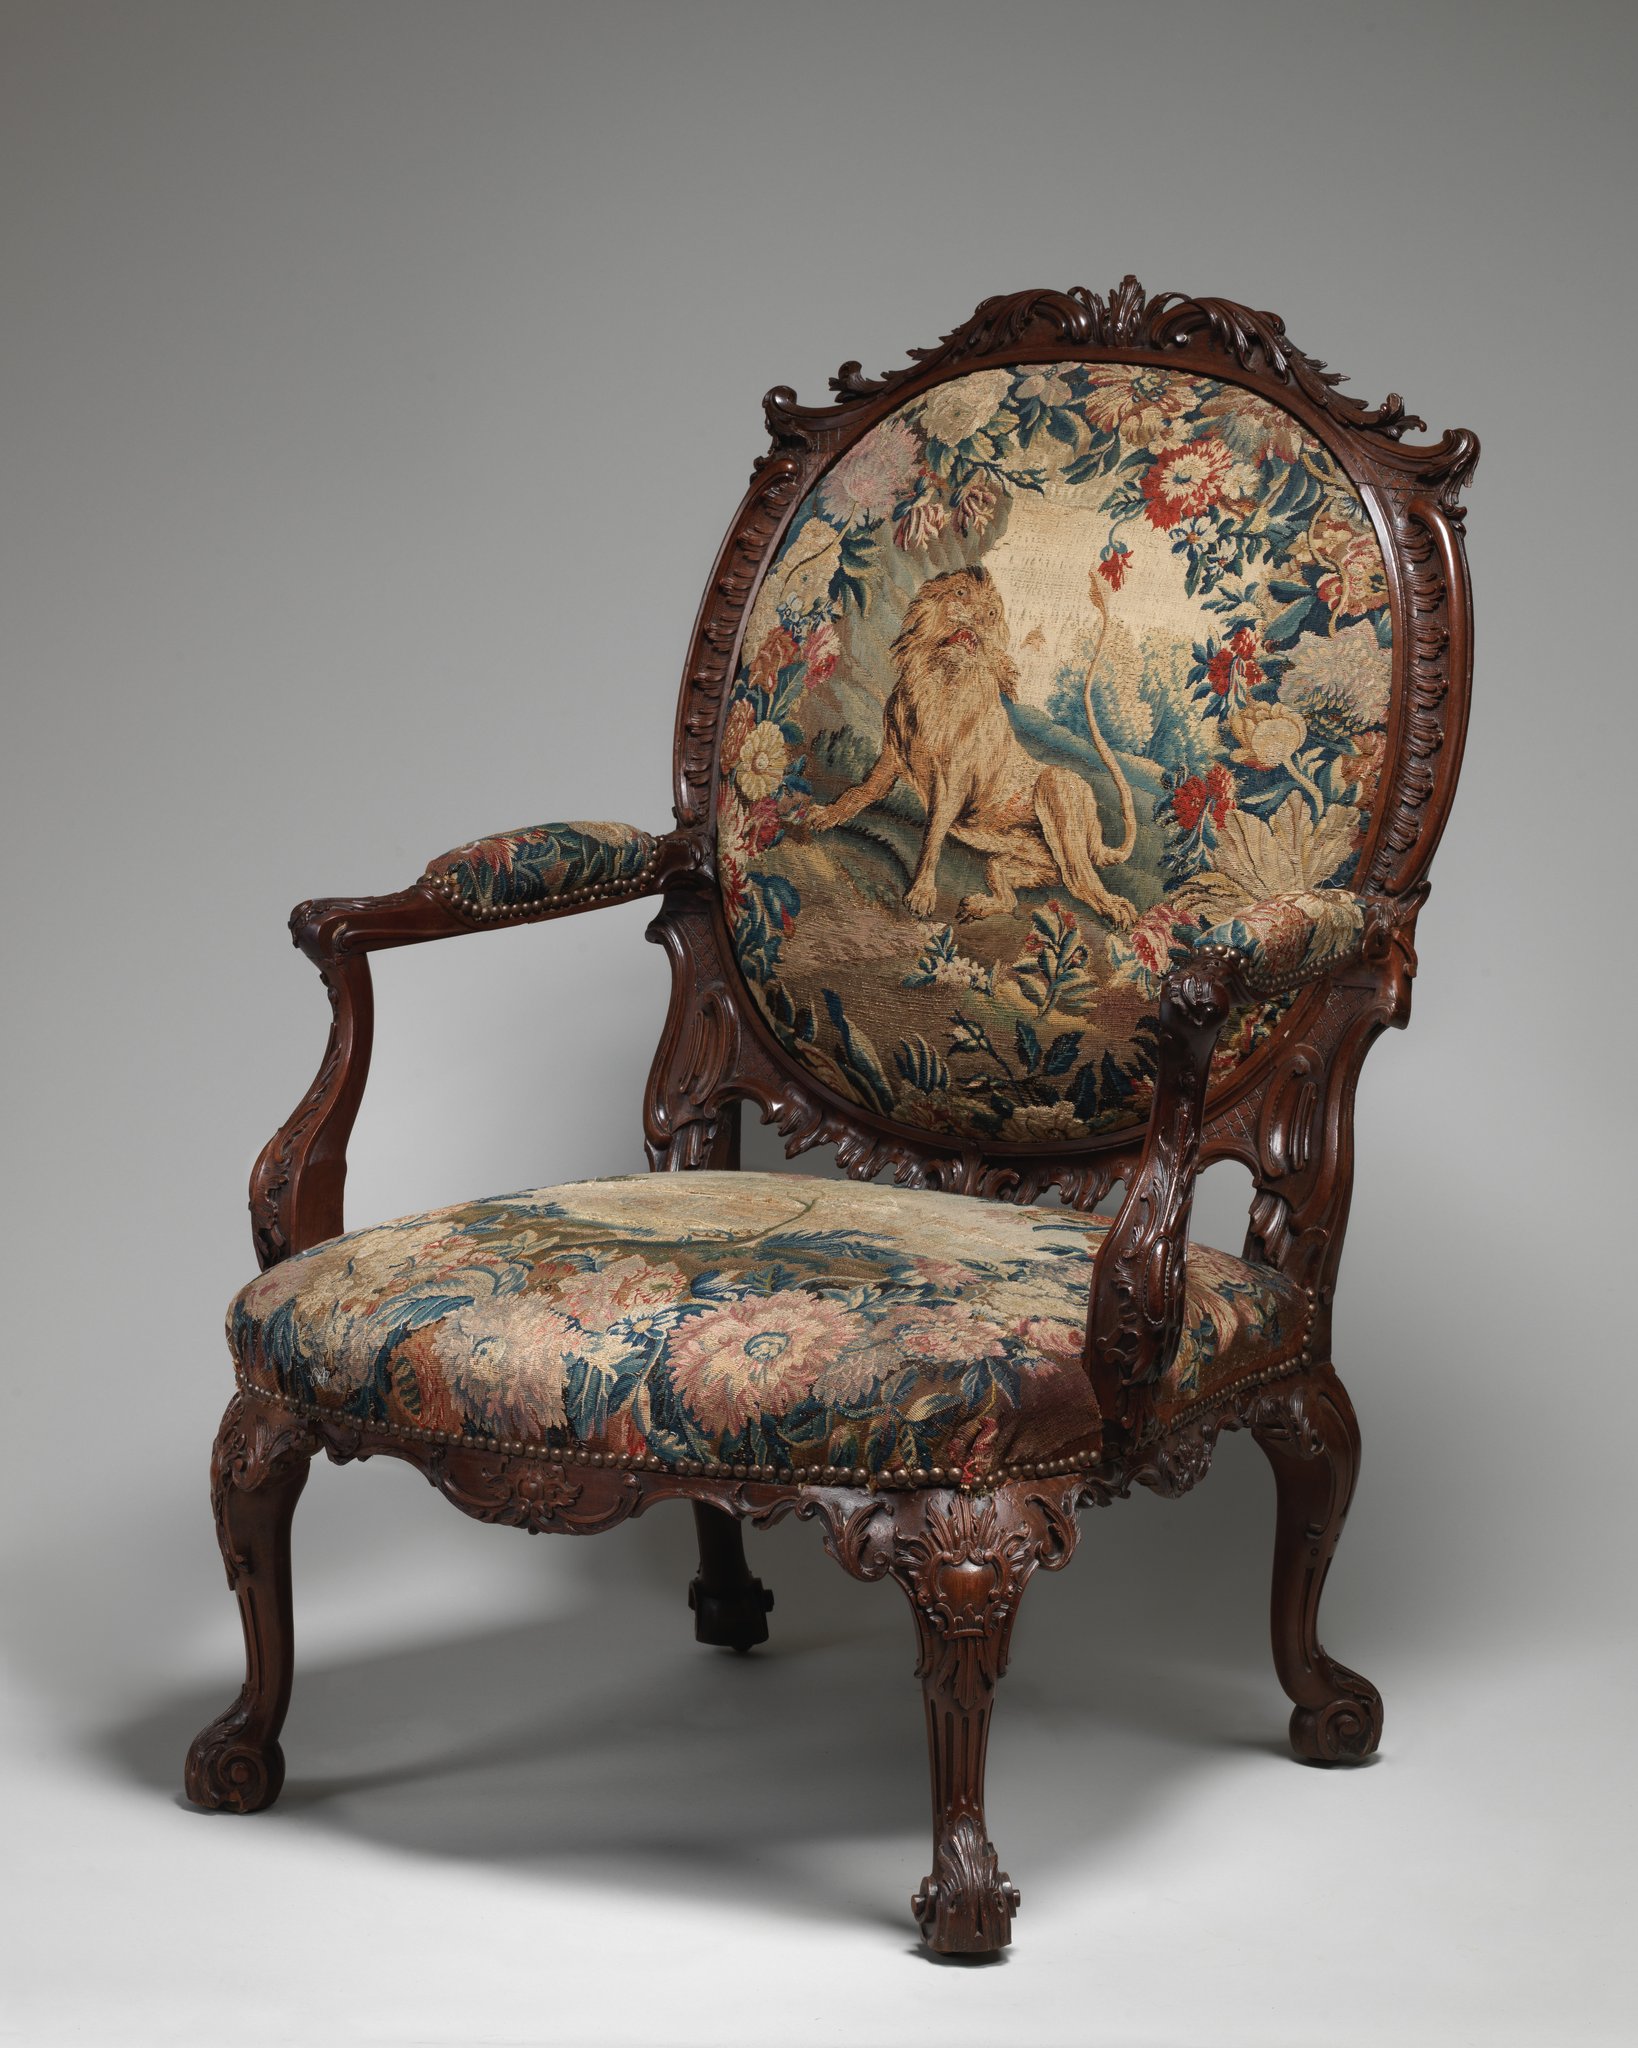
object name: armchair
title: Armchair (one of four)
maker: royal manufactory beauvais 1664-1789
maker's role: factory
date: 1755-1765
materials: wood, silk, wool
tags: lions